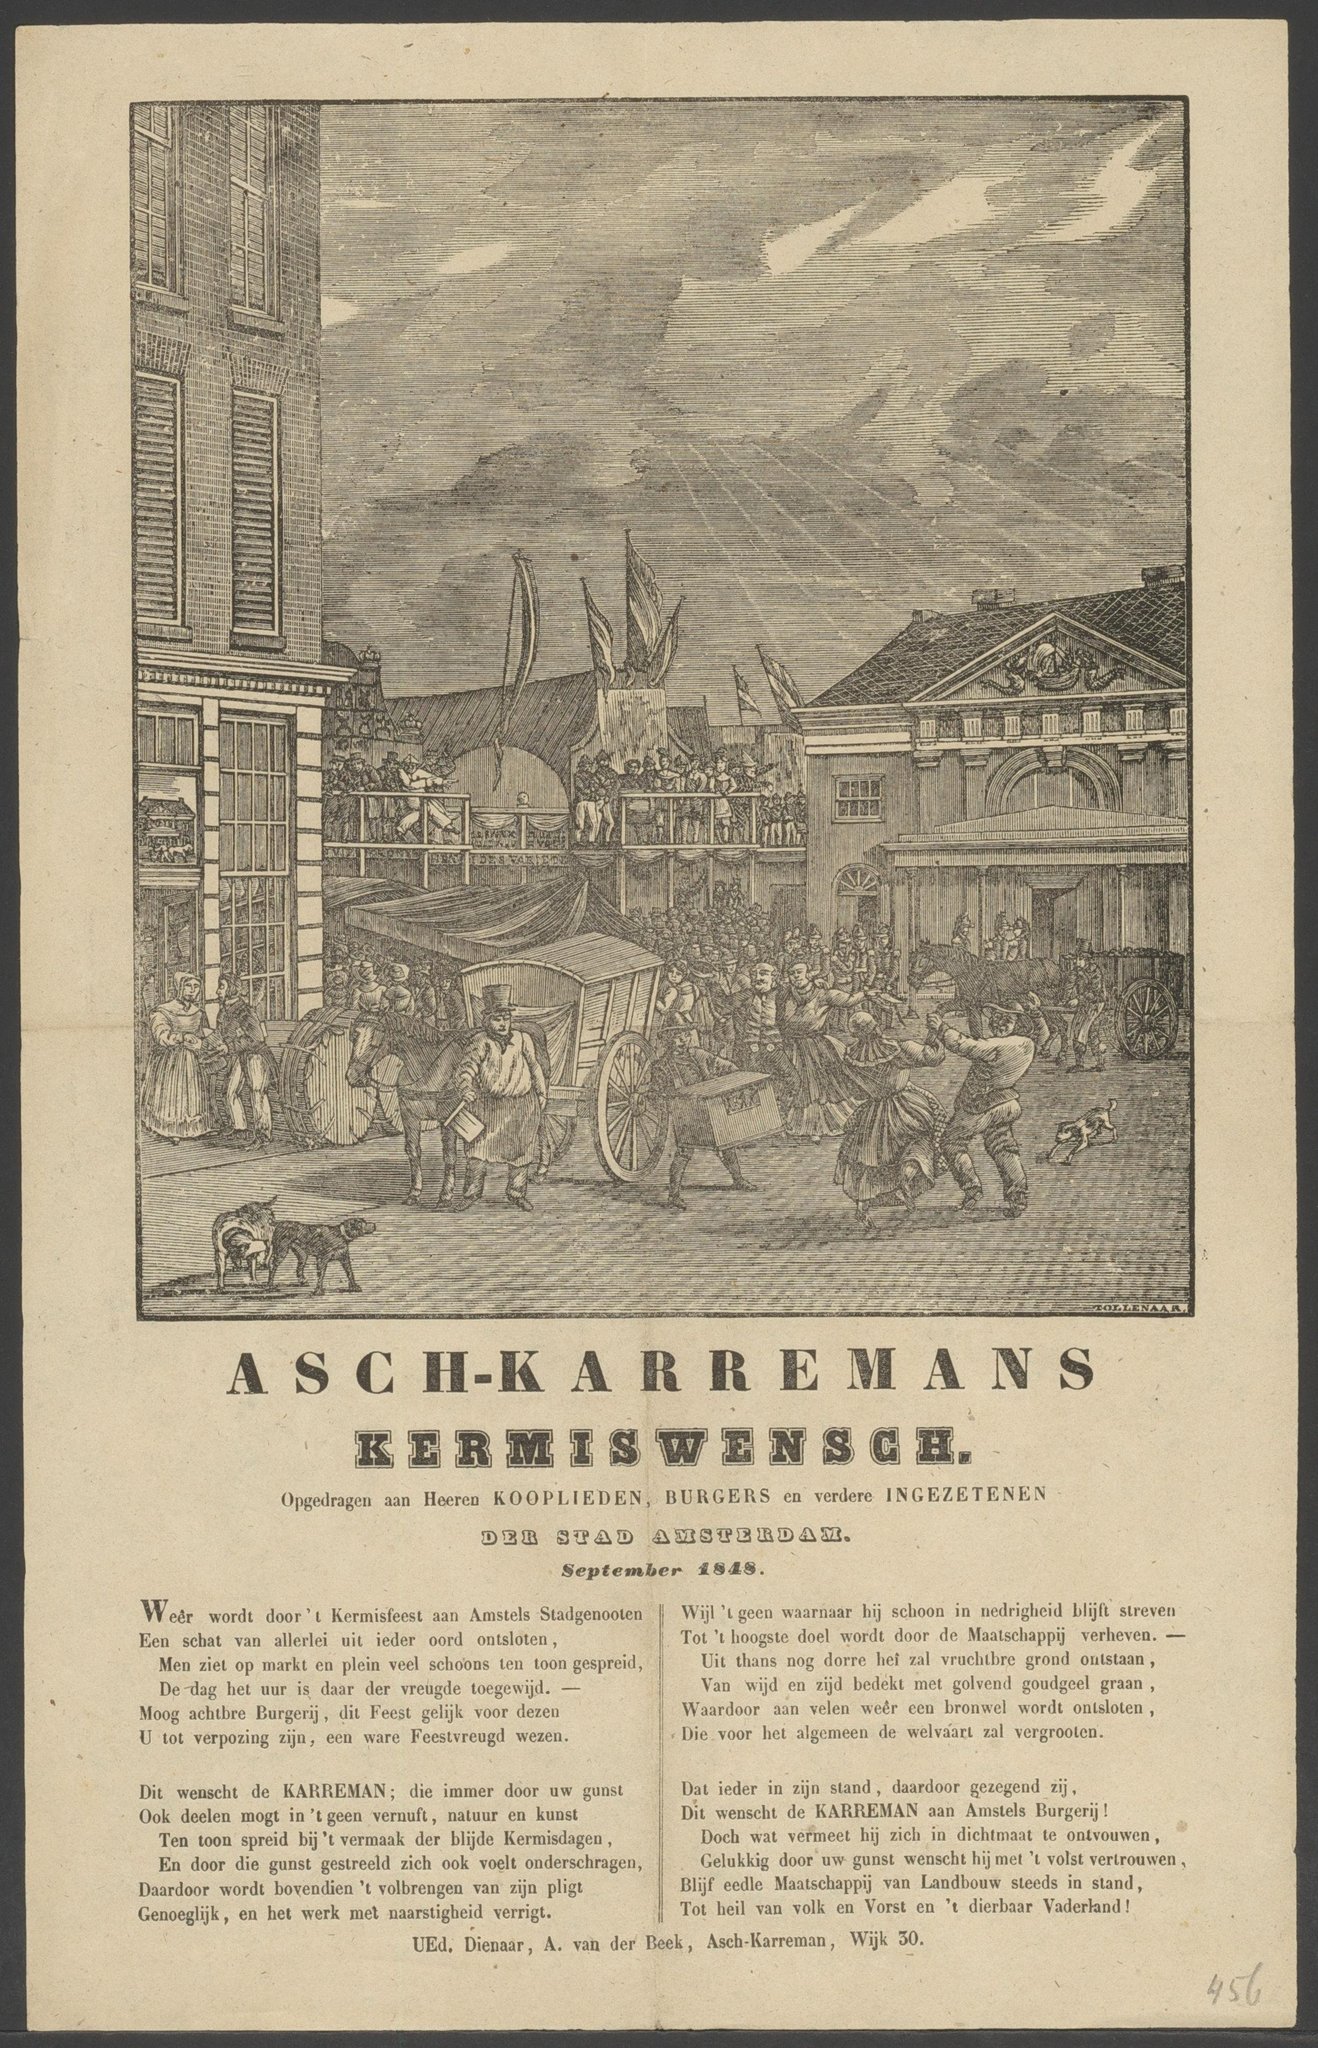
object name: fair print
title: Kermisprent van de Amsterdamse askarrenmannen voor het jaar 1848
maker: dirk wijbrand tollenaar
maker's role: print maker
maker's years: 1808-1858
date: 1848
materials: paper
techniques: letterpress printing, engraving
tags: pleasure fair and circus, garbage collection, amsterdam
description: Kermisprent namens de askarrenmannen (karrenman of vuilnisman) te Amsterdam, september 1848. Gezicht op de kermis op de Botermarkt met de Regulierswaag. Op de markt twee vuilniskarren. Onderaan een gedicht in twee kolommen. Namens Abraham van der Beek, de askarreman van wijk no. 30. Onderwerpsrubrieken binnen de Atlas Zeden en Gewoonten: Zeden en gewoonten in engeren zin, Volksleven, Volksbladen, Nieuwjaars- en Kerstwenschen, Amsterdam.